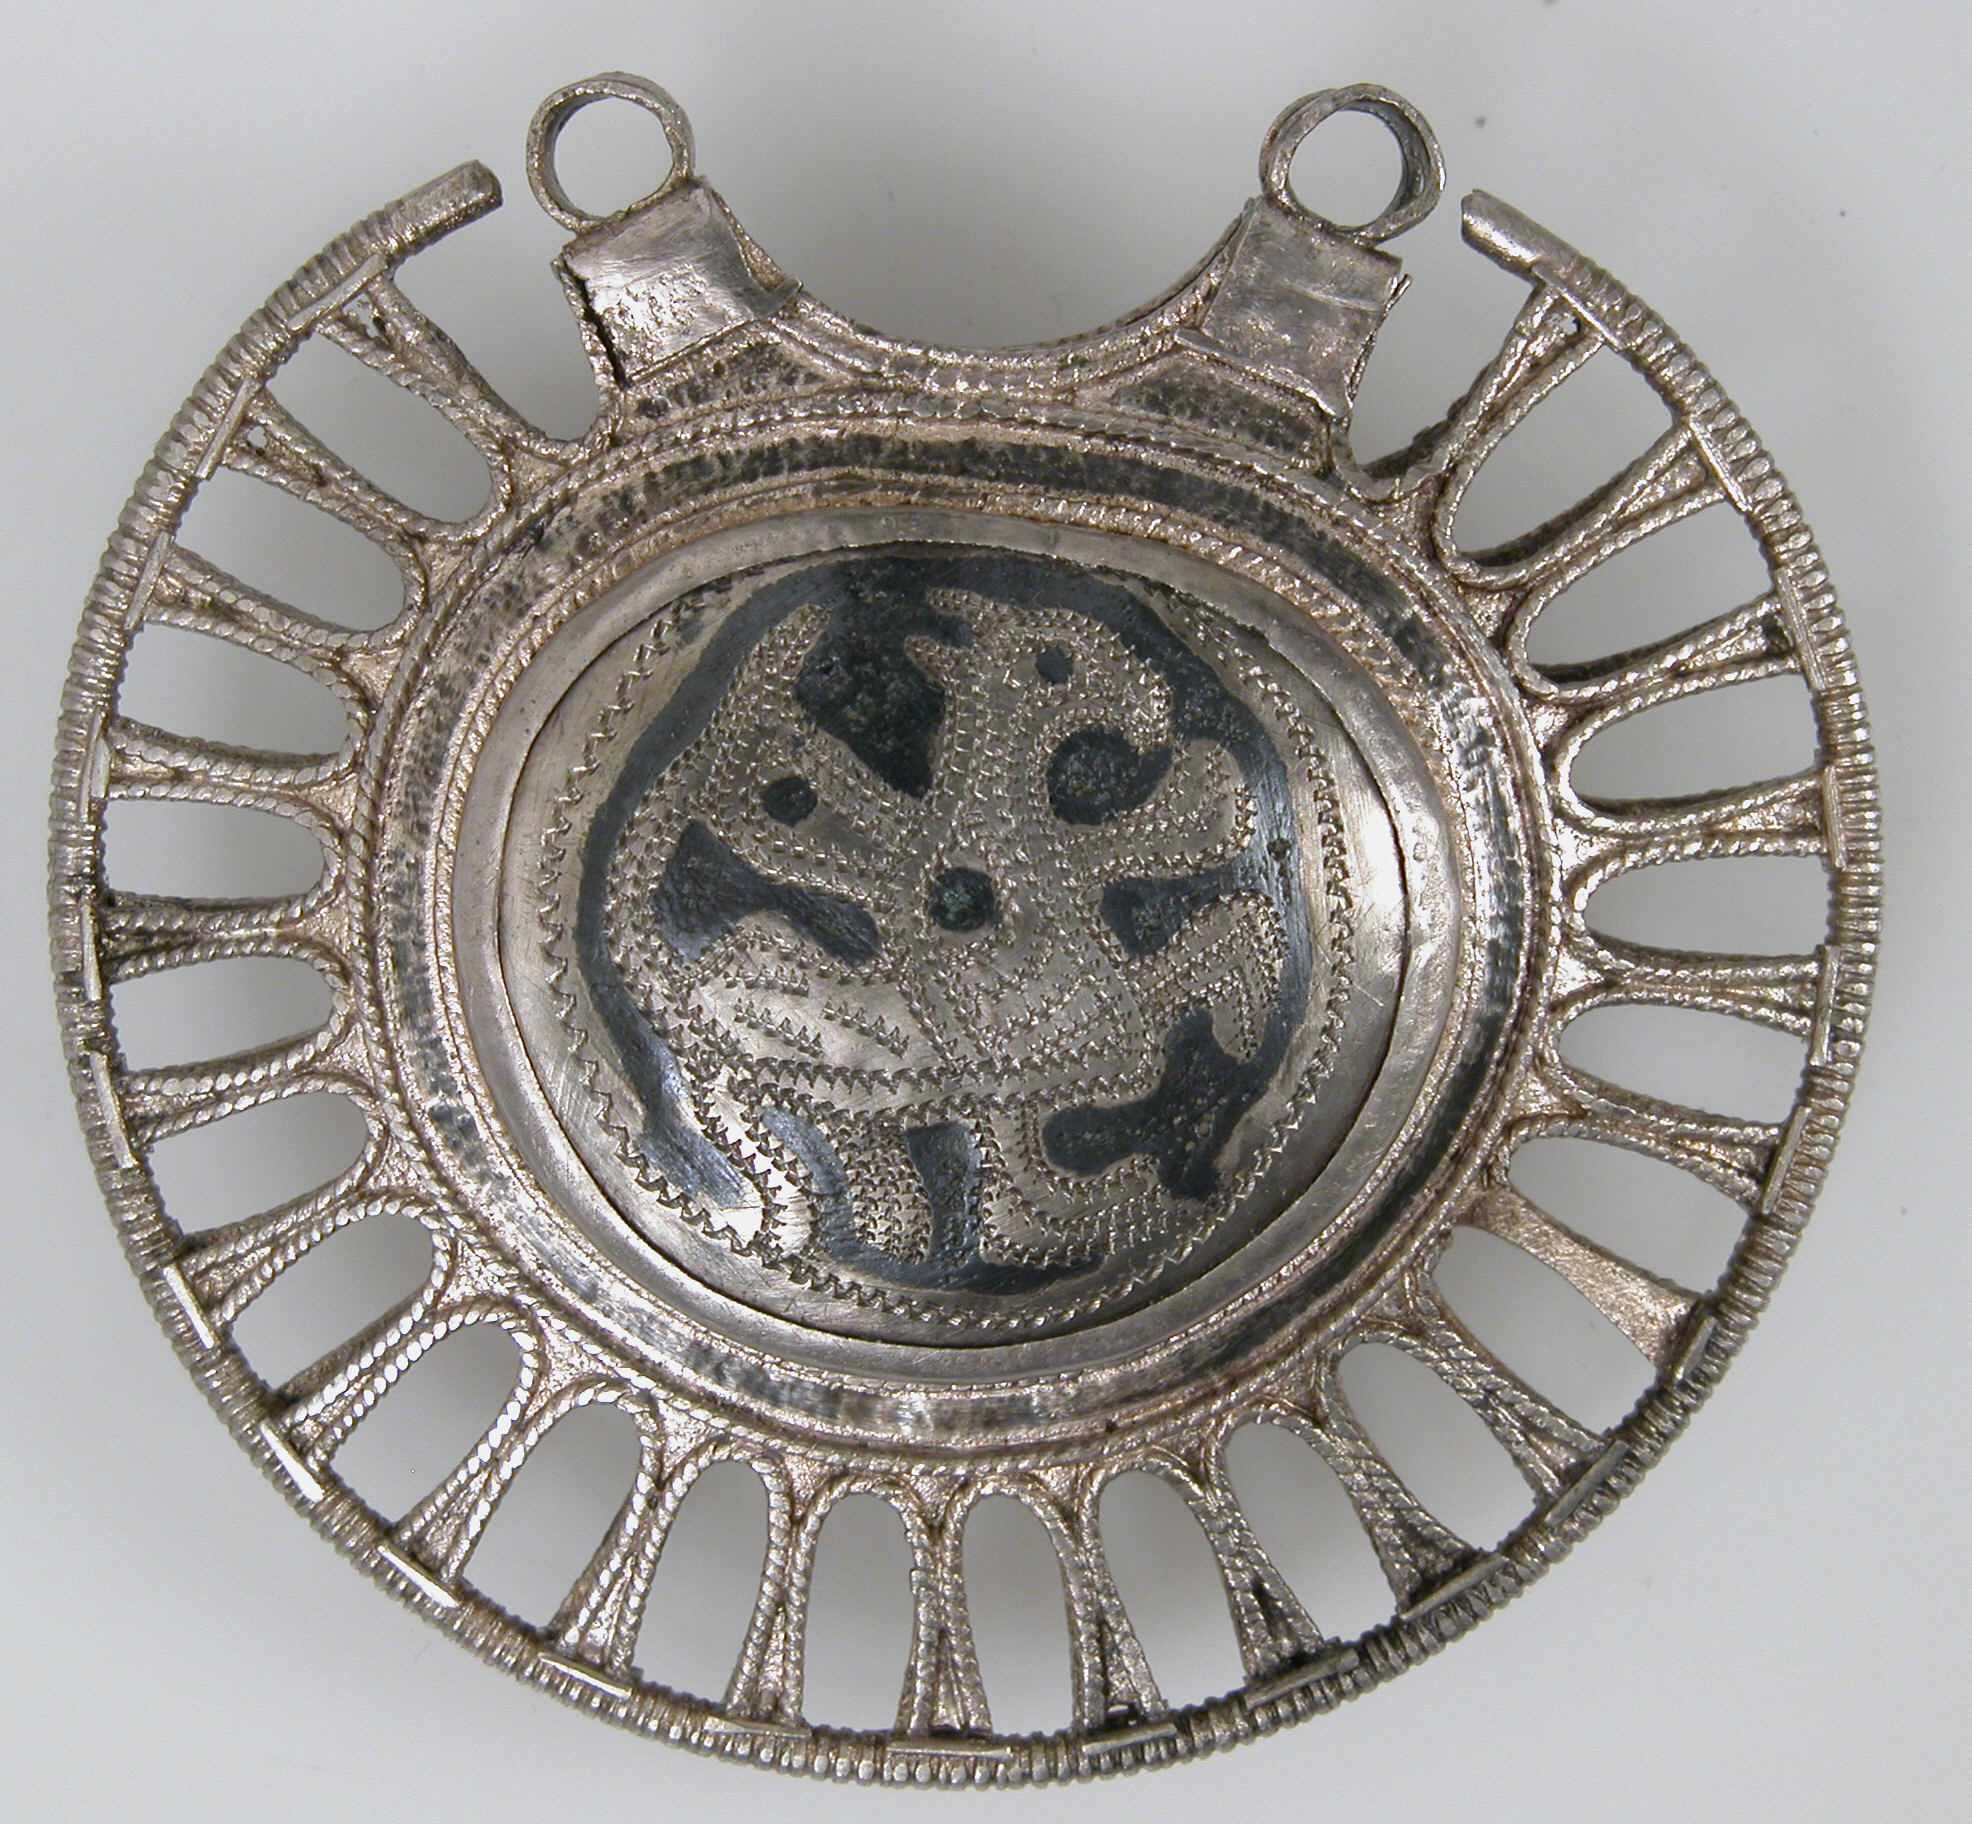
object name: temple pendant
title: Temple Pendant with Filigree Border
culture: kyivan rus’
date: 1001-1200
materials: niello, silver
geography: ukraine